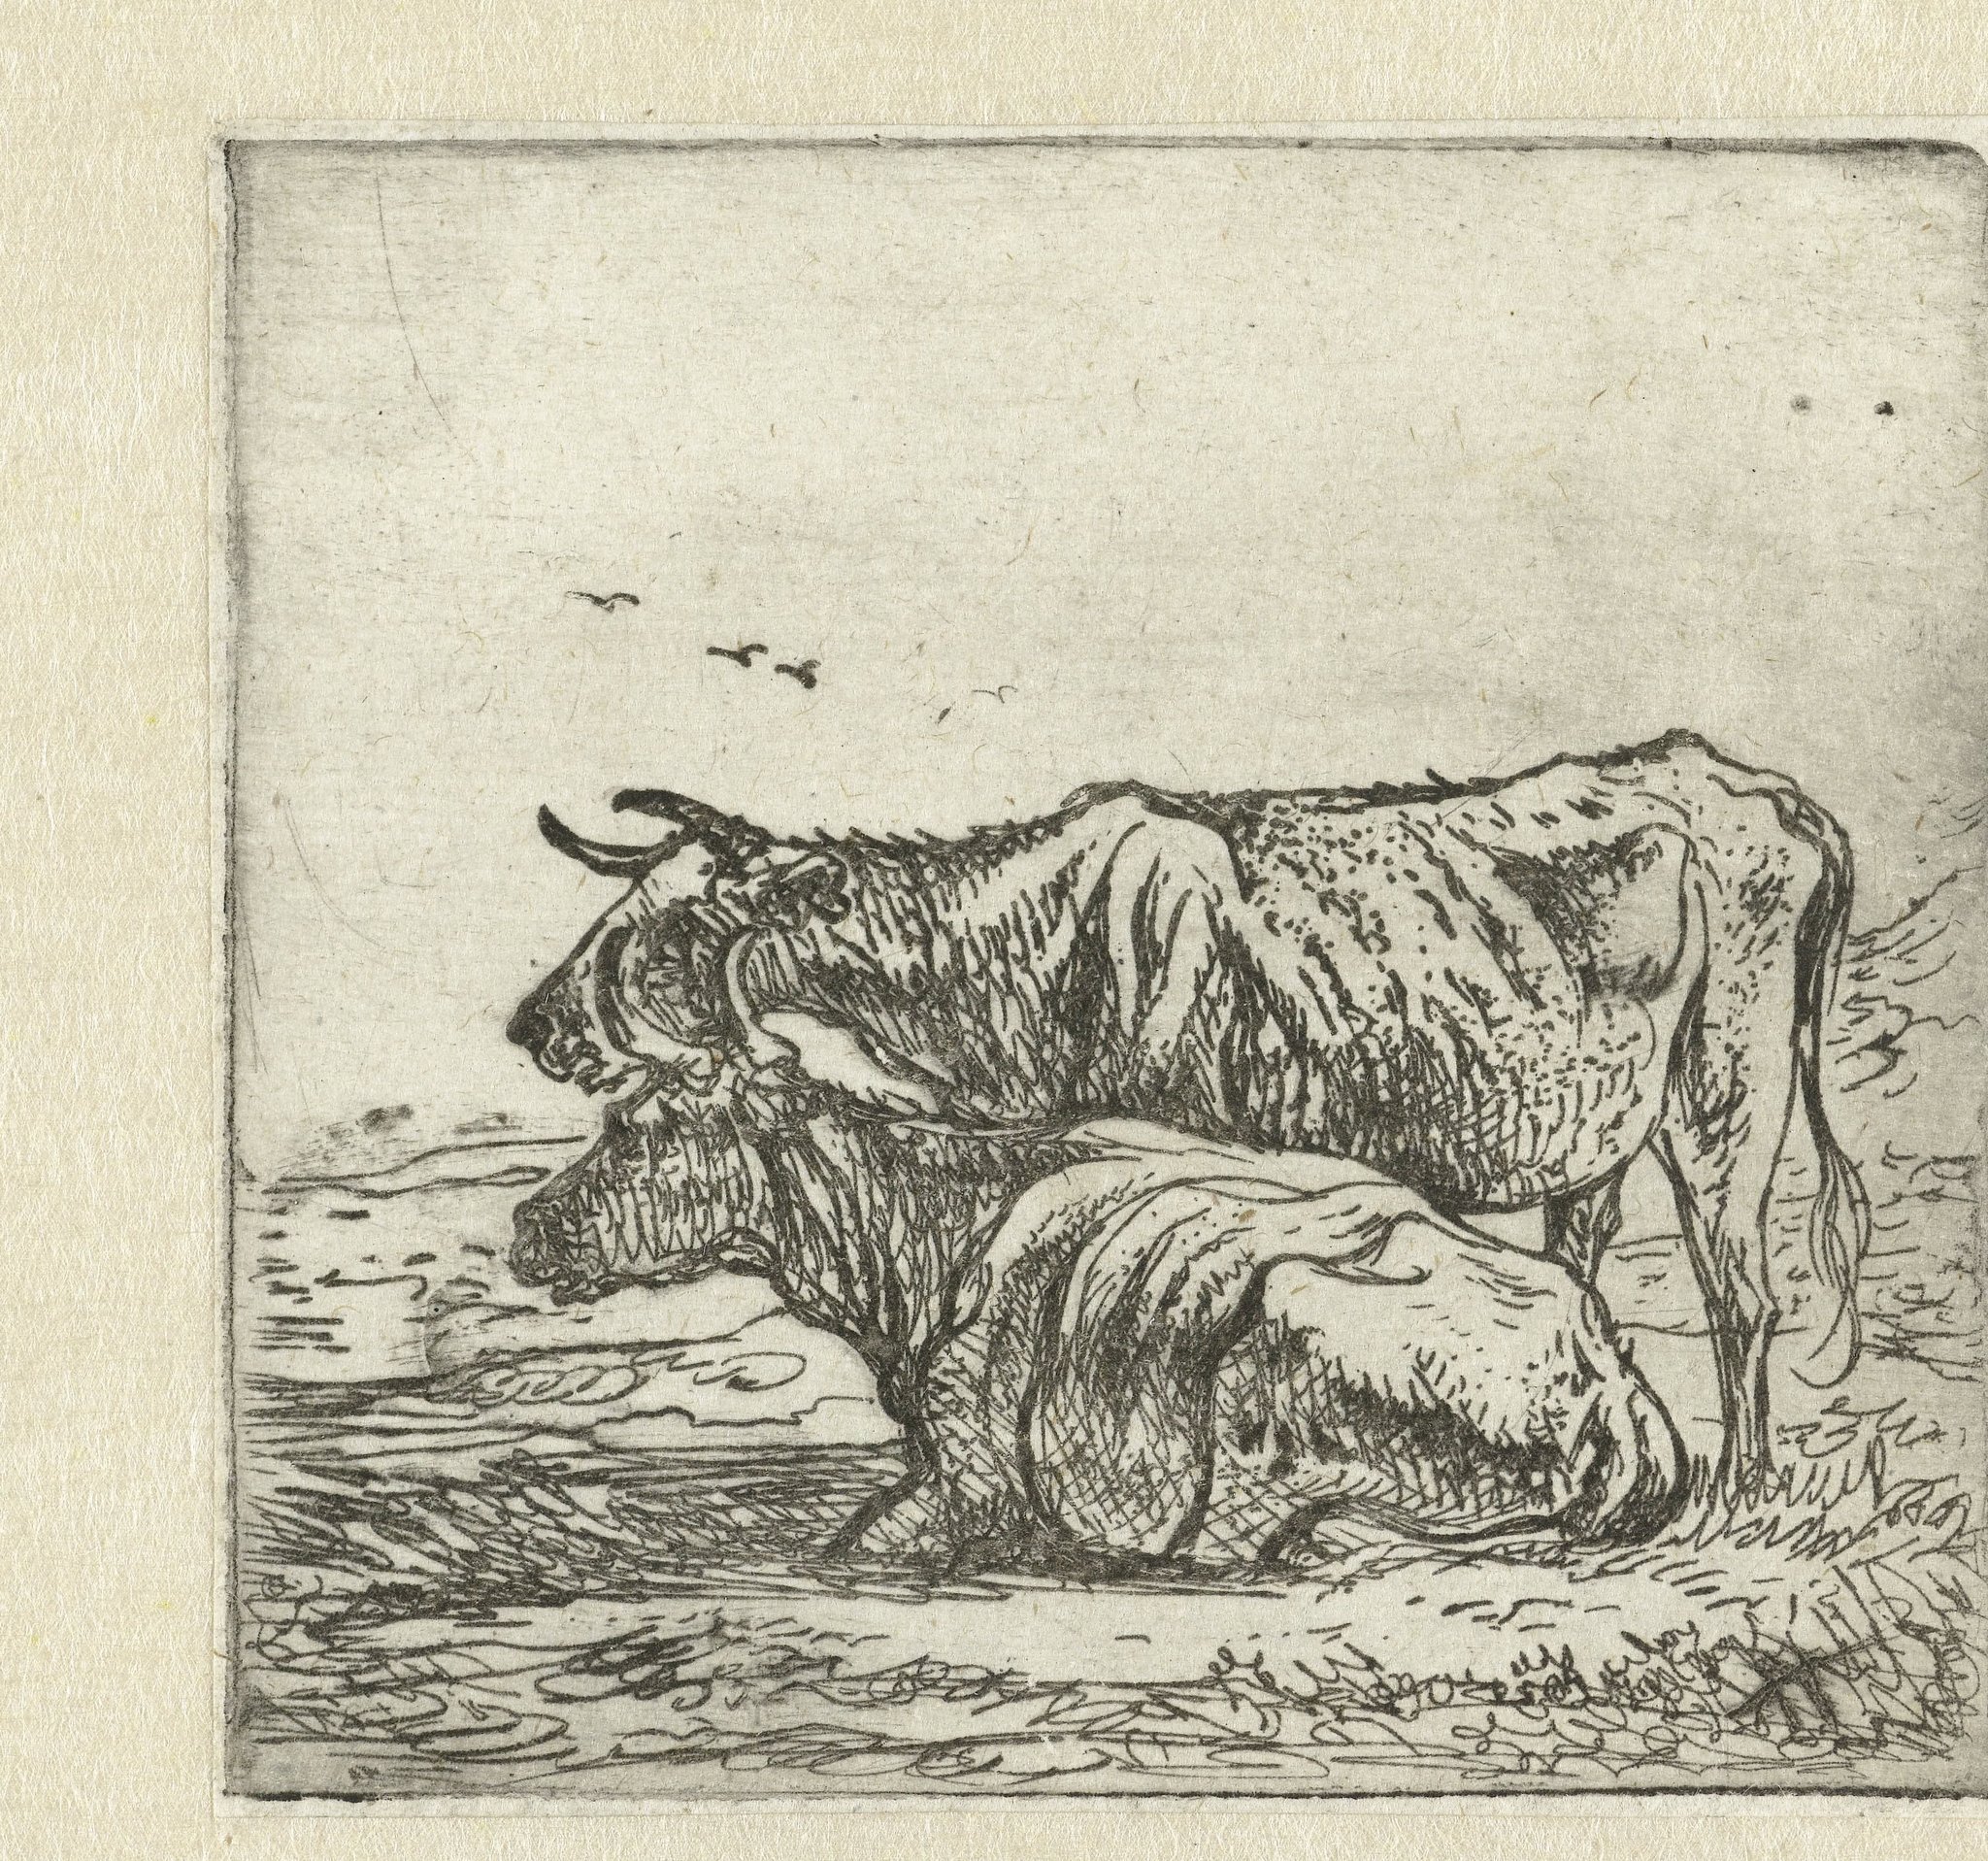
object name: print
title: Twee koeien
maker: aelbert cuyp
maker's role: draughtsman, painter, print maker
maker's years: 1620-1691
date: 1630-1691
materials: paper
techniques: etching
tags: cow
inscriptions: collector's mark: Lugt 2228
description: Prent uit serie van zes prenten met koeien.